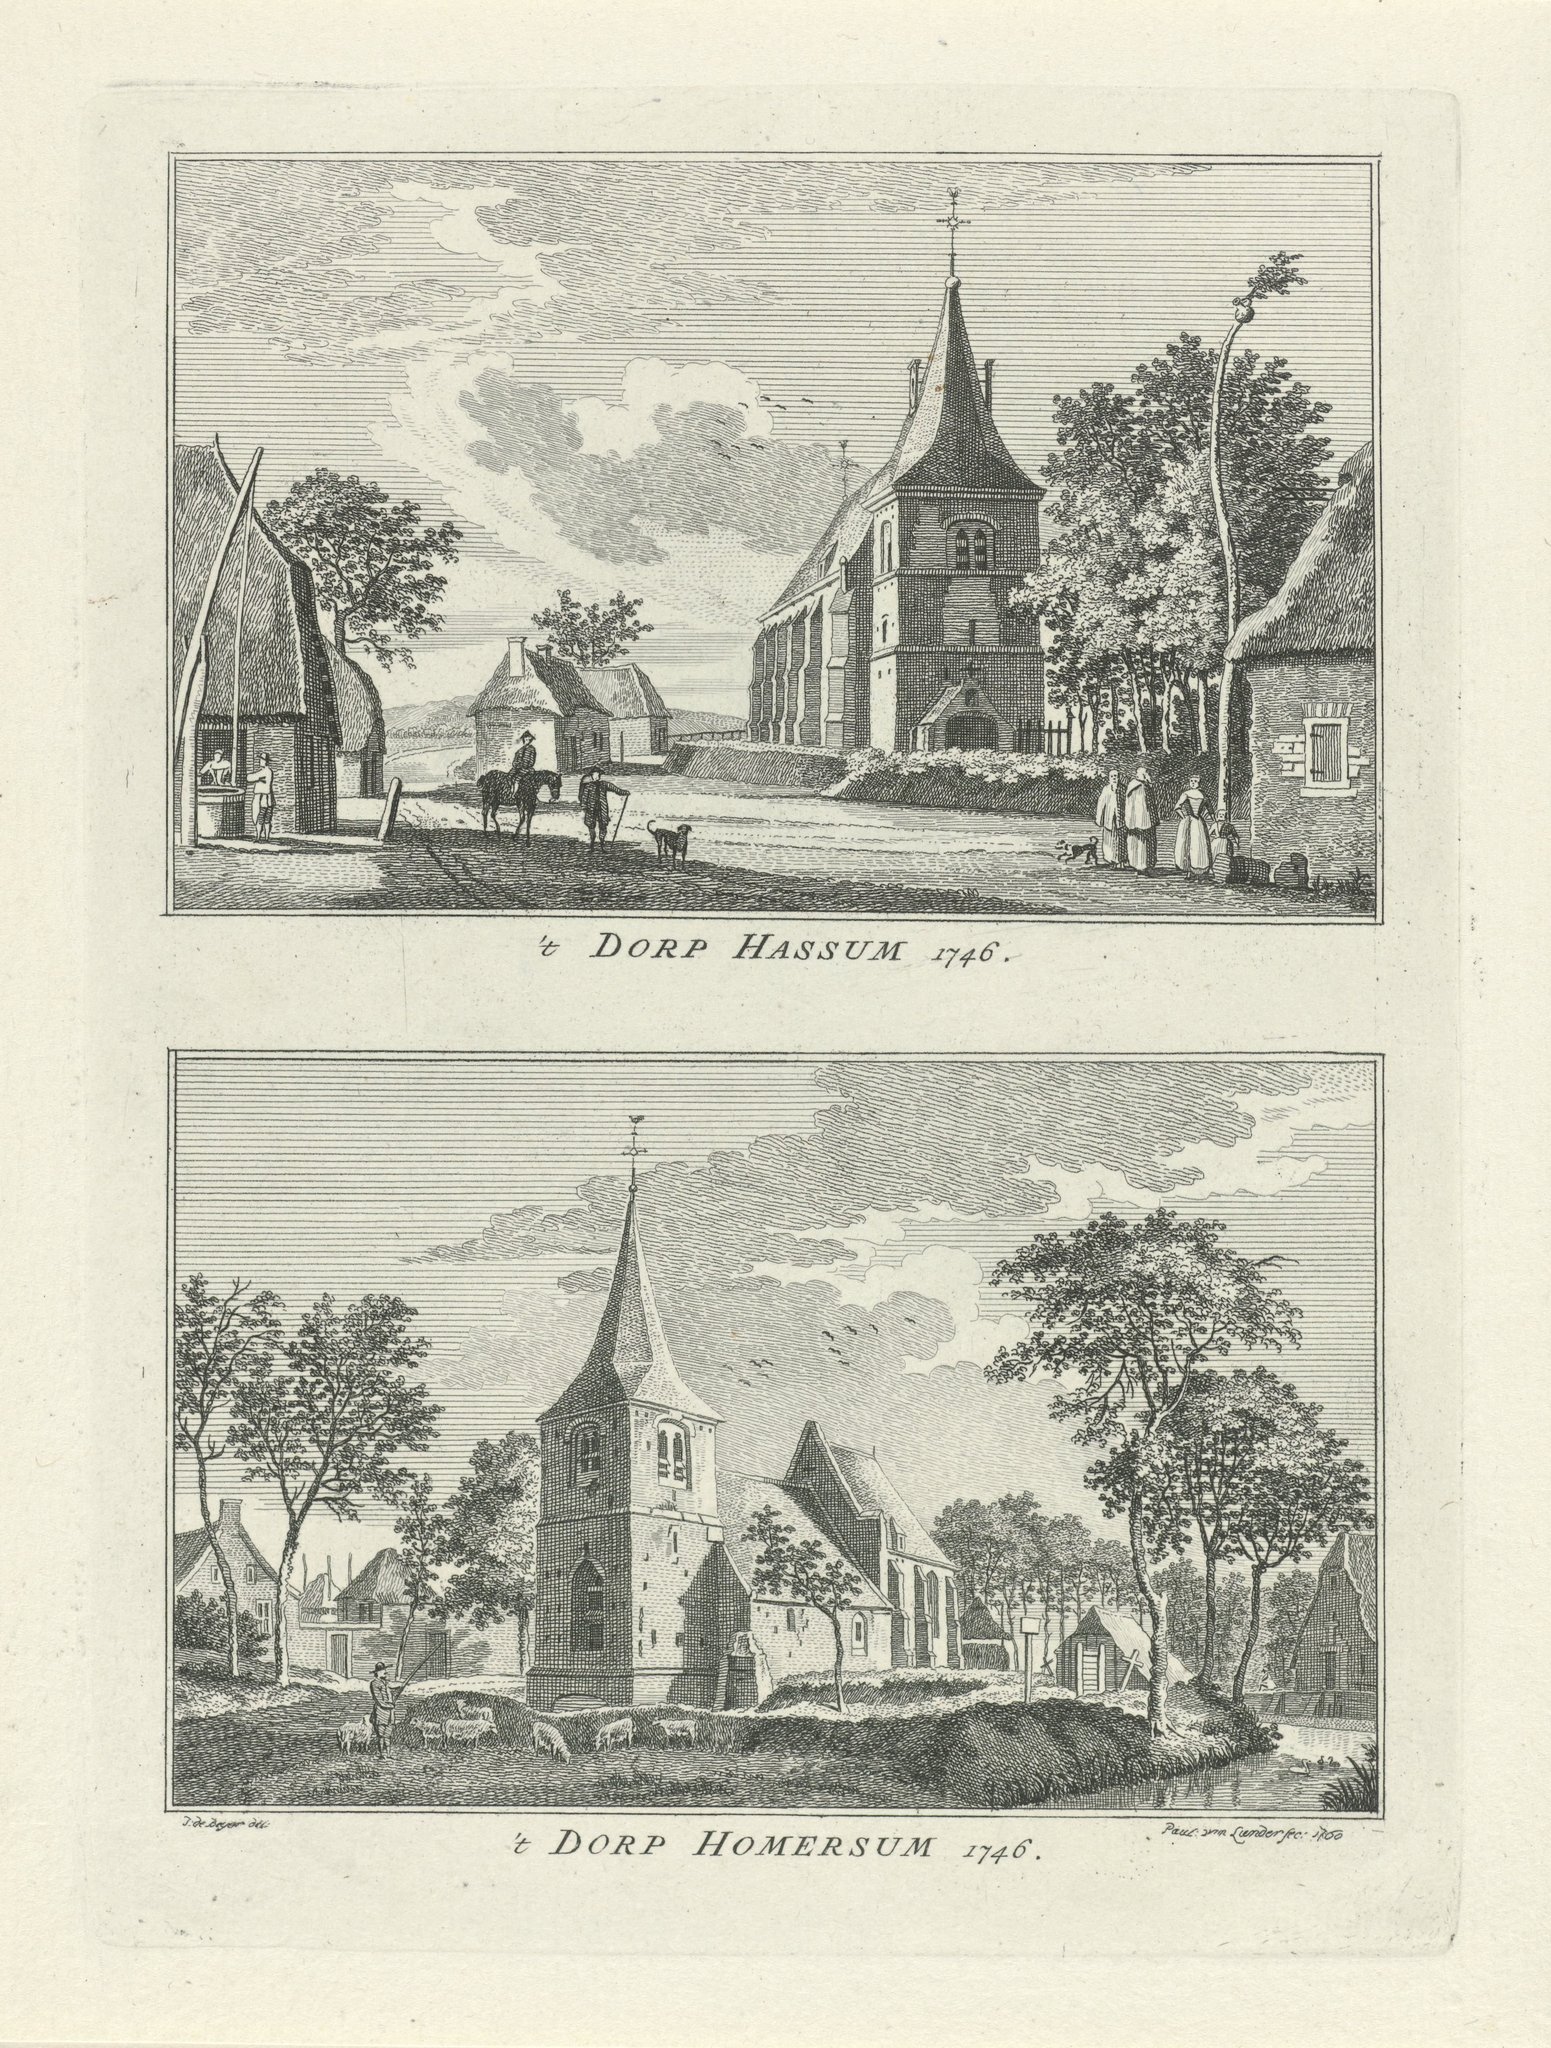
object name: print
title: 't Dorp Hassum 1746 / 't Dorp Homersum 1746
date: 1760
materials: paper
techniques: etching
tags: village, church (exterior)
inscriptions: collector's mark: Lugt 240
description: Twee voorstellingen van één plaat. Gezichten op de Duitse dorpen Hassum (boven) en Hommersum (onder), met kerk. De prent maakt deel uit van een 100-delige serie met gezichten op dorpen en steden te Kleef.